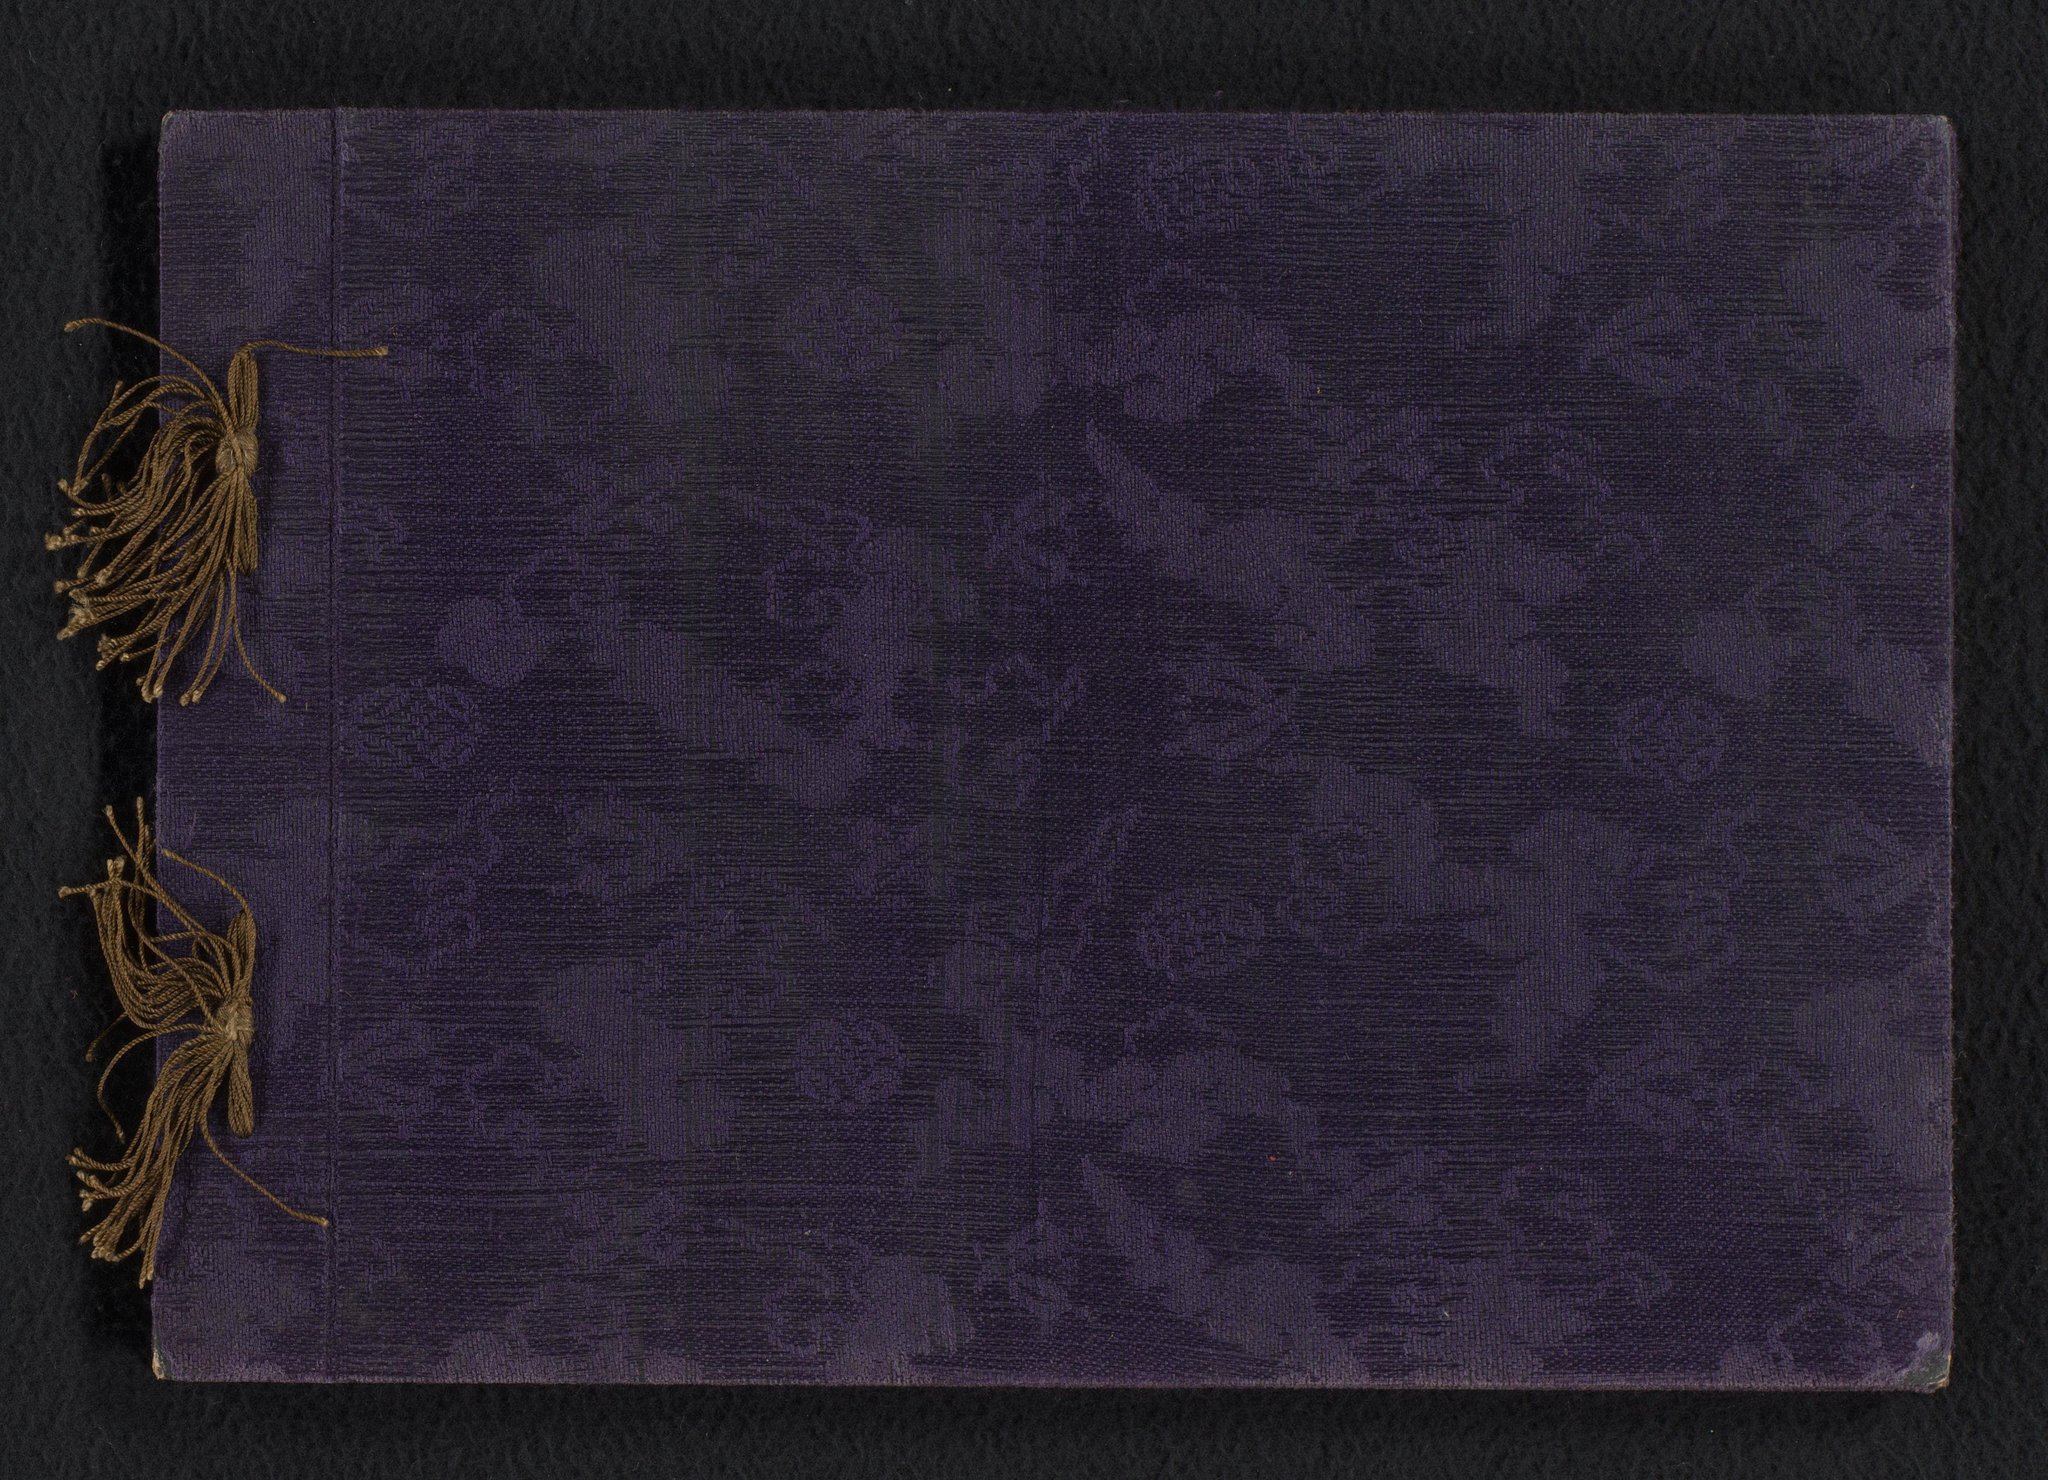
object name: book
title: The New Year in Japan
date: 1906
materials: paper, textile, yarns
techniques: photograph, hand coloring, letterpress printing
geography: kobe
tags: children's games and plays, festivities falling on calendar dates; memorial days, making music; musician with instrument, group games, party games, market, cleaning (the house), tea-ceremony, japan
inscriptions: number: ‘350’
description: Boek met 24 lichtdrukken waarop diverse Nieuwjaarstradities uit Japan zijn afgebeeld.